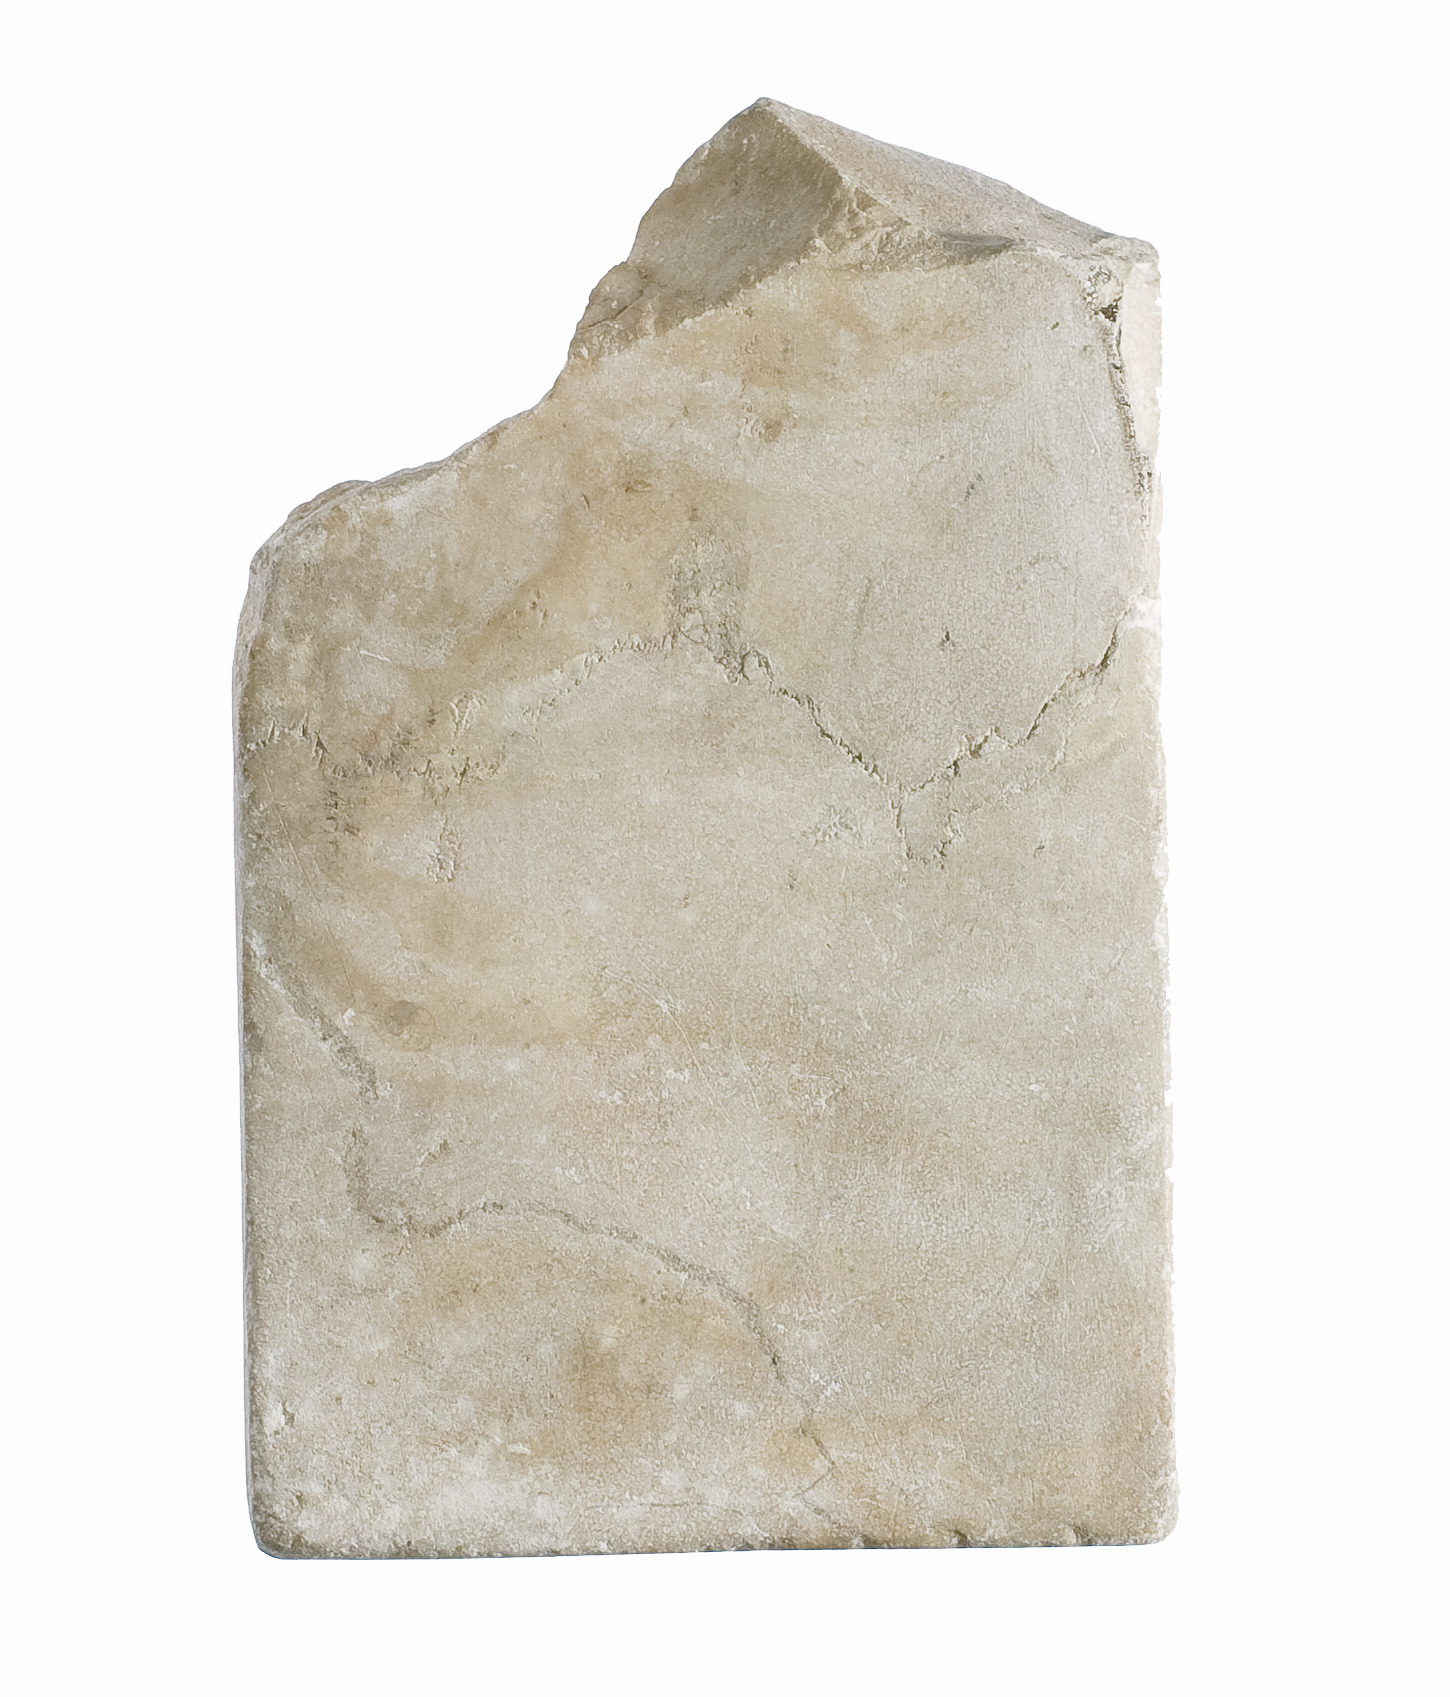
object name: offering table fragment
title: Offering table (?) fragment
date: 1353-1336 BCE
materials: limestone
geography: egypt